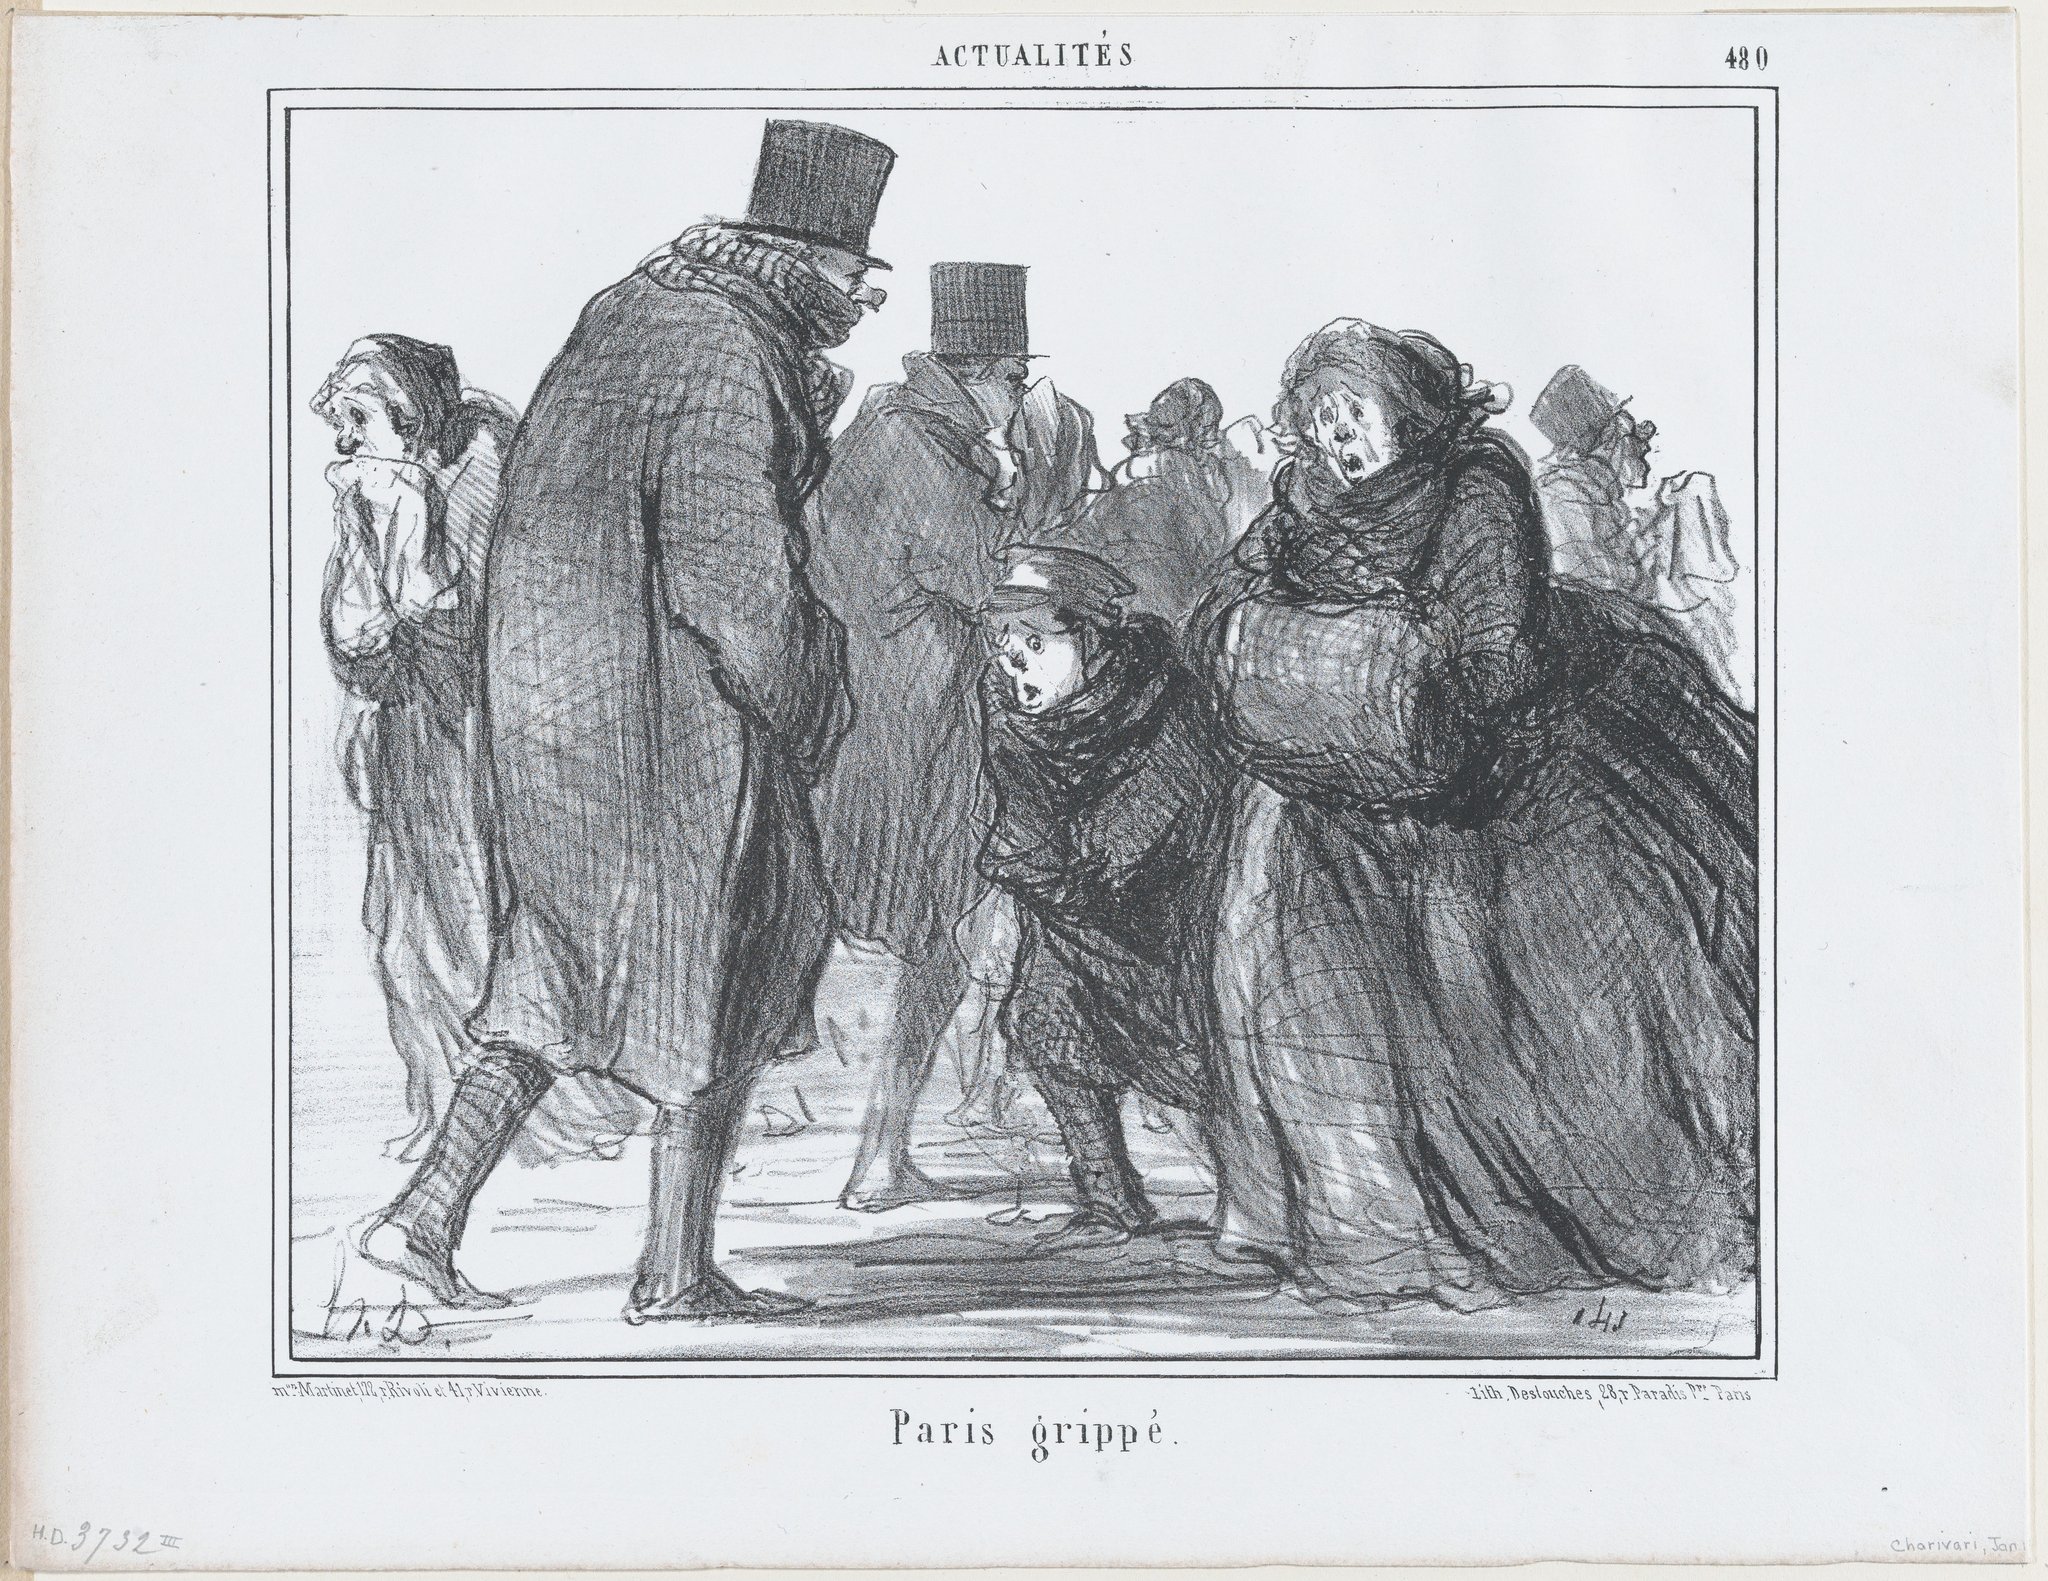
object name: print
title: Paris Grippé, from Actualités, published in "Le Charivari"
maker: honoré daumier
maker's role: artist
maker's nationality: french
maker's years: 1808-1879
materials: paper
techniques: lithograph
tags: men,women